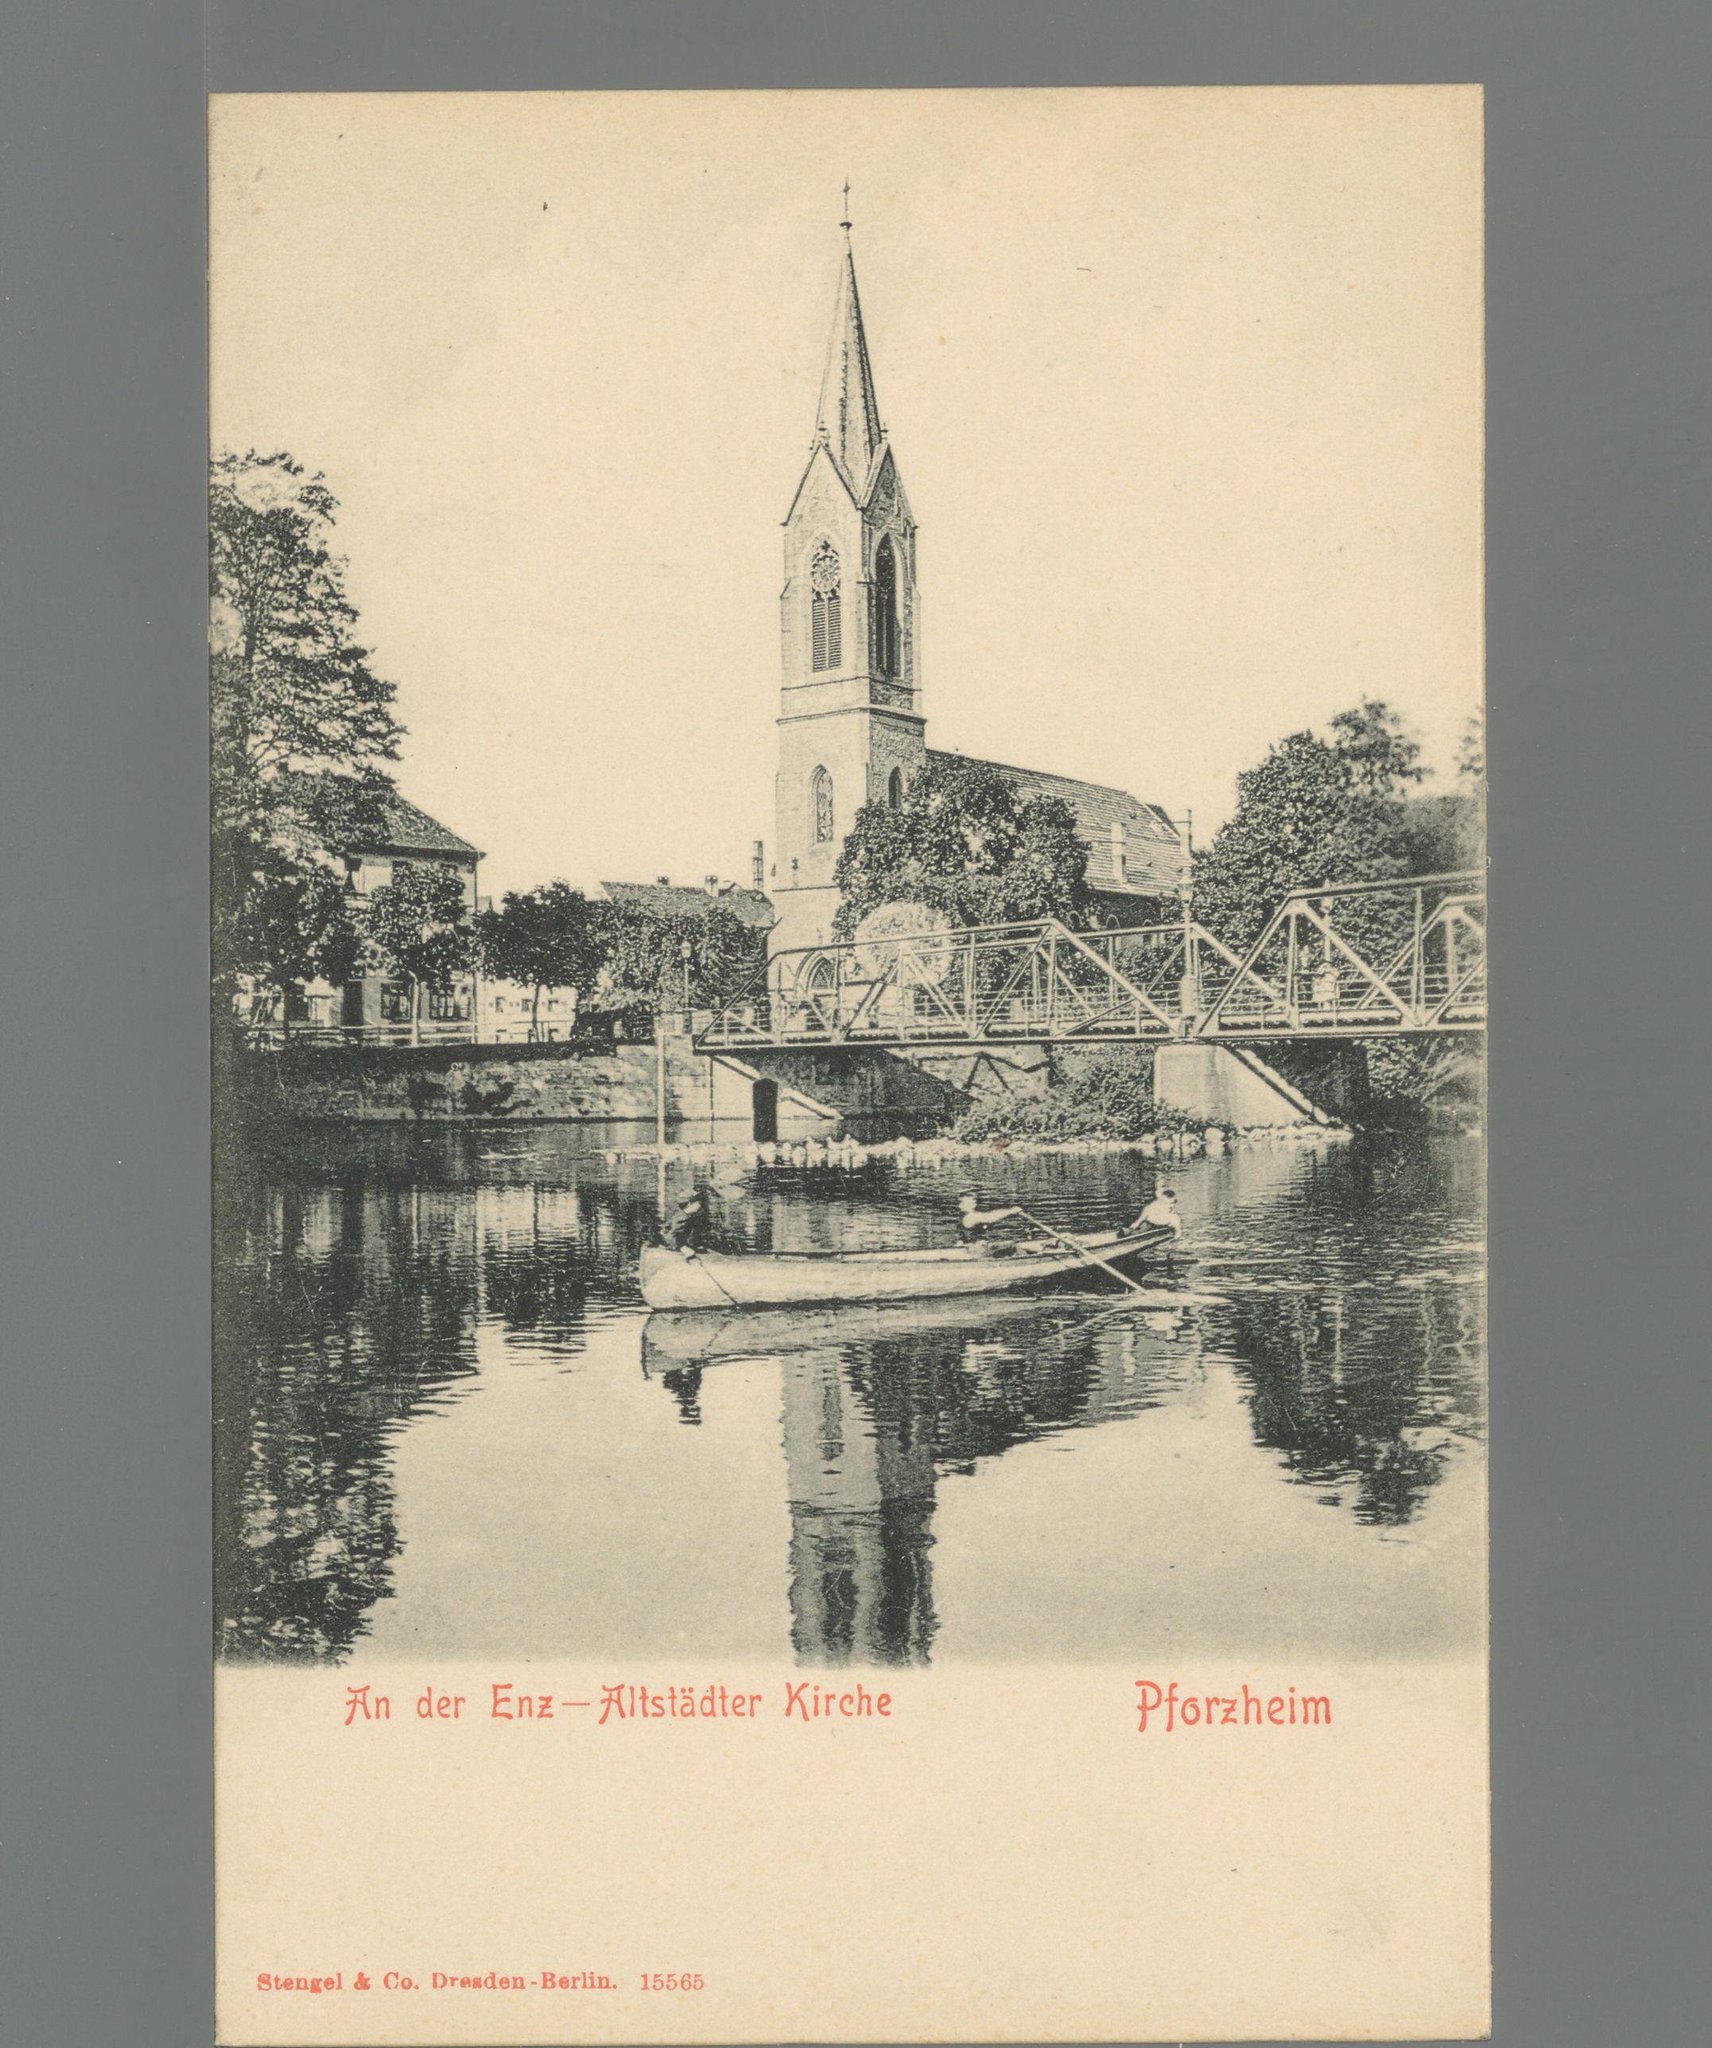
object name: ansichtkaart, prentbriefkaart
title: An der Enz - Altstädter Kirche. Pforzheim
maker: Anonymous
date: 1889-1905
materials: cardboard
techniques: photograph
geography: dresden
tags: church (exterior), canals, waters (in city), bridge in city across river, canal, etc.